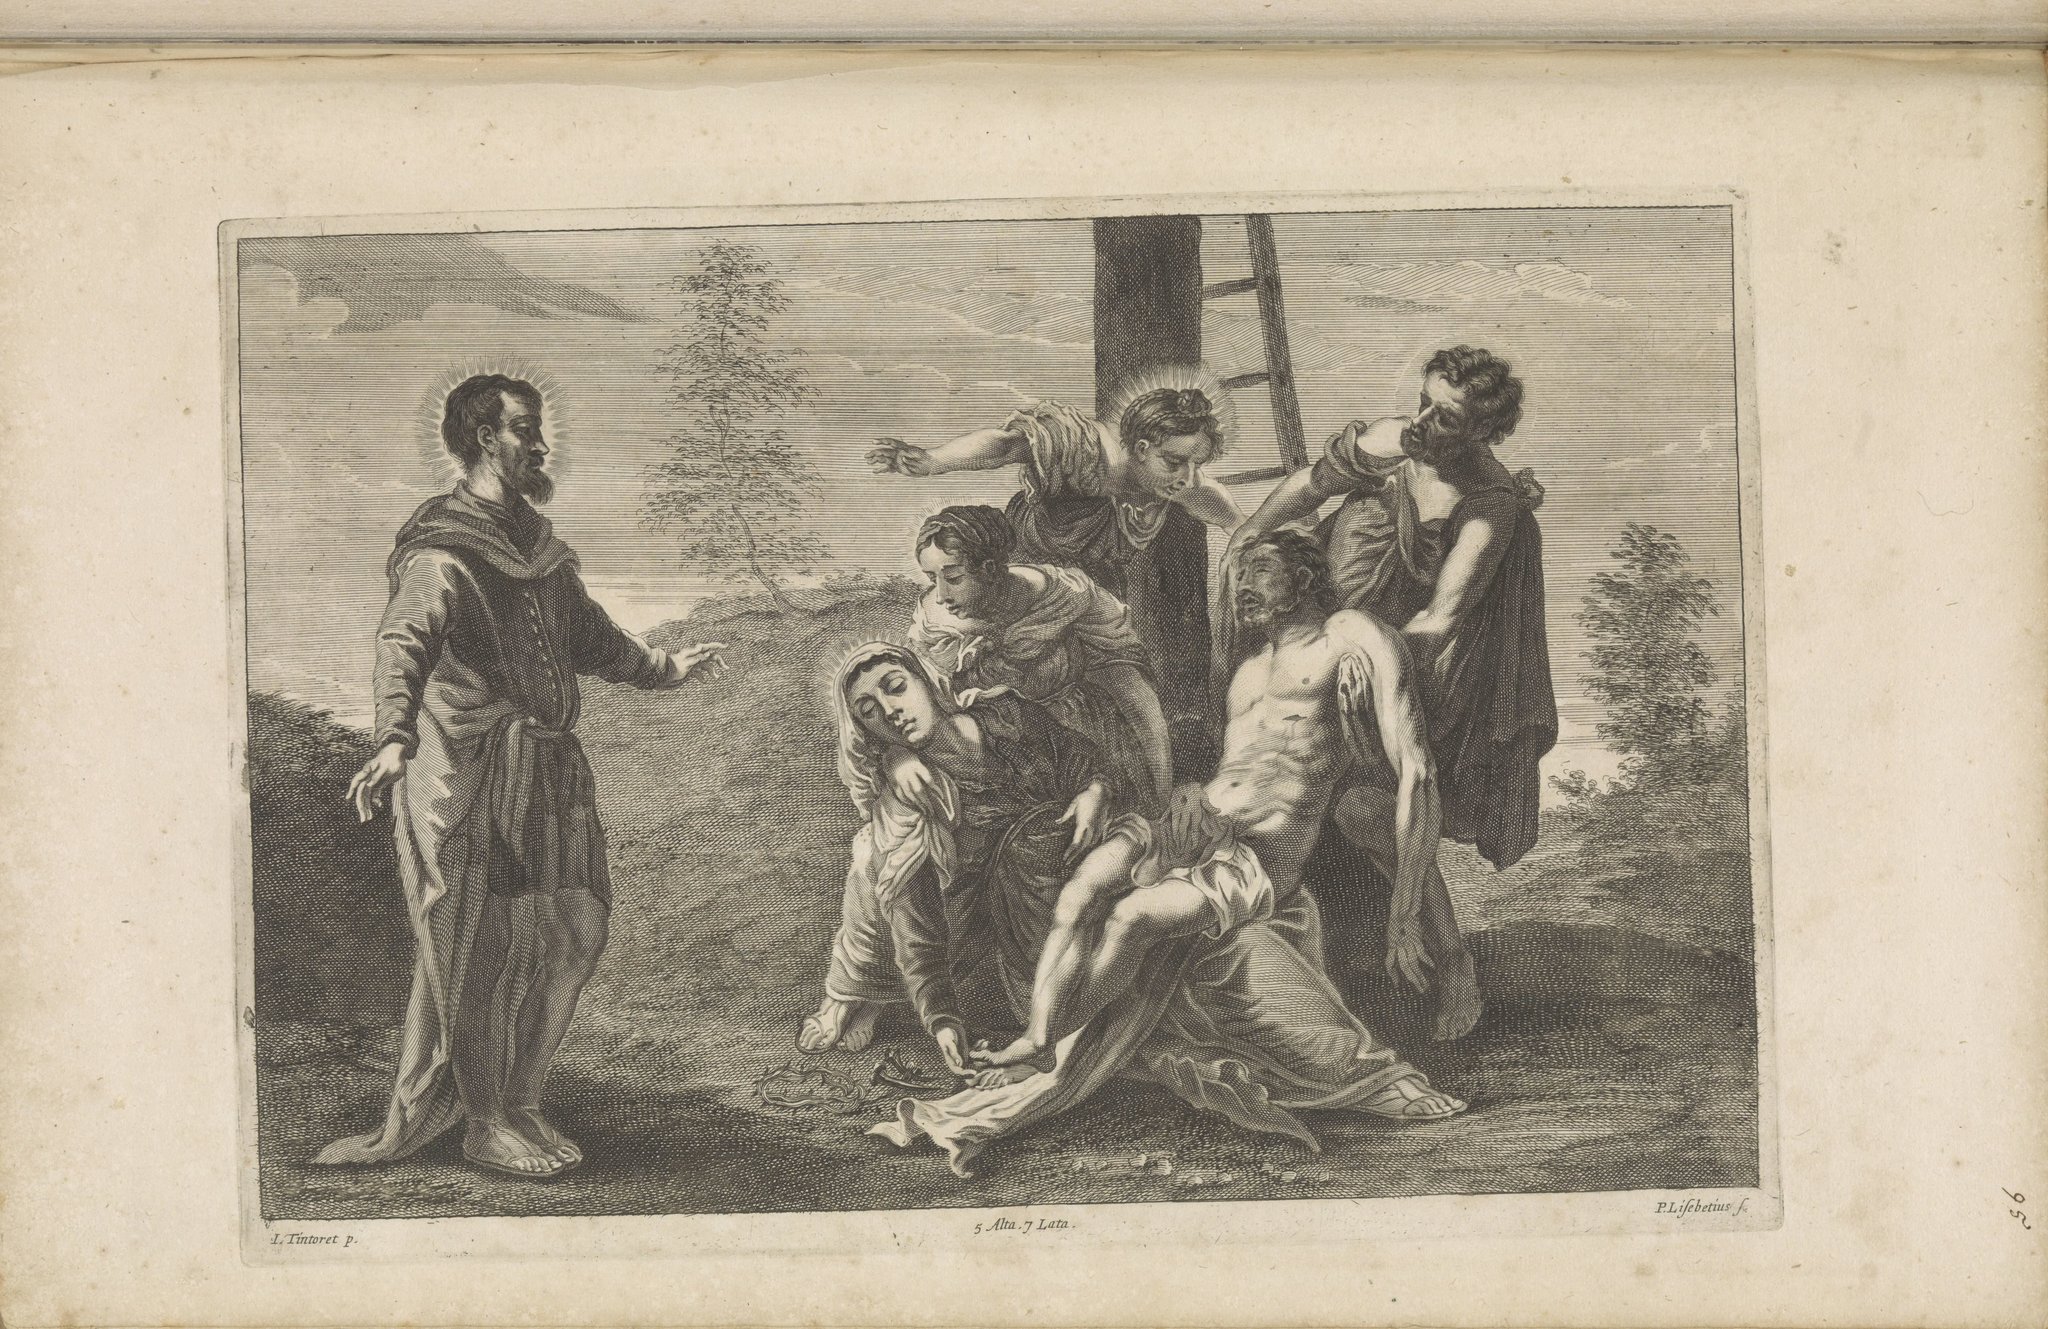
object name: album leaf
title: Kruisafneming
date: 1660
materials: paper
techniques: engraving, etching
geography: antwerp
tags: christ is laid down ~ descent from the cross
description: De prent is vervaardigd naar het schilderij van Tintoretto dat zich in de collectie van het Kunsthistorisches Museum te Wenen bevindt (inventarisnummer GG_1565). David Teniers heeft waarschijnlijk van alle schilderijen uit de collectie van Leopold Willem van Oostenrijk een olieverfstudie op doek of paneel vervaardigd (zgn. pasticcio), die als voorbeeld voor de prentmakers diende. Het is niet altijd duidelijk of de pasticci door hem zijn gemaakt of door zijn atelier. Niet alle pasticci zijn overgeleverd.